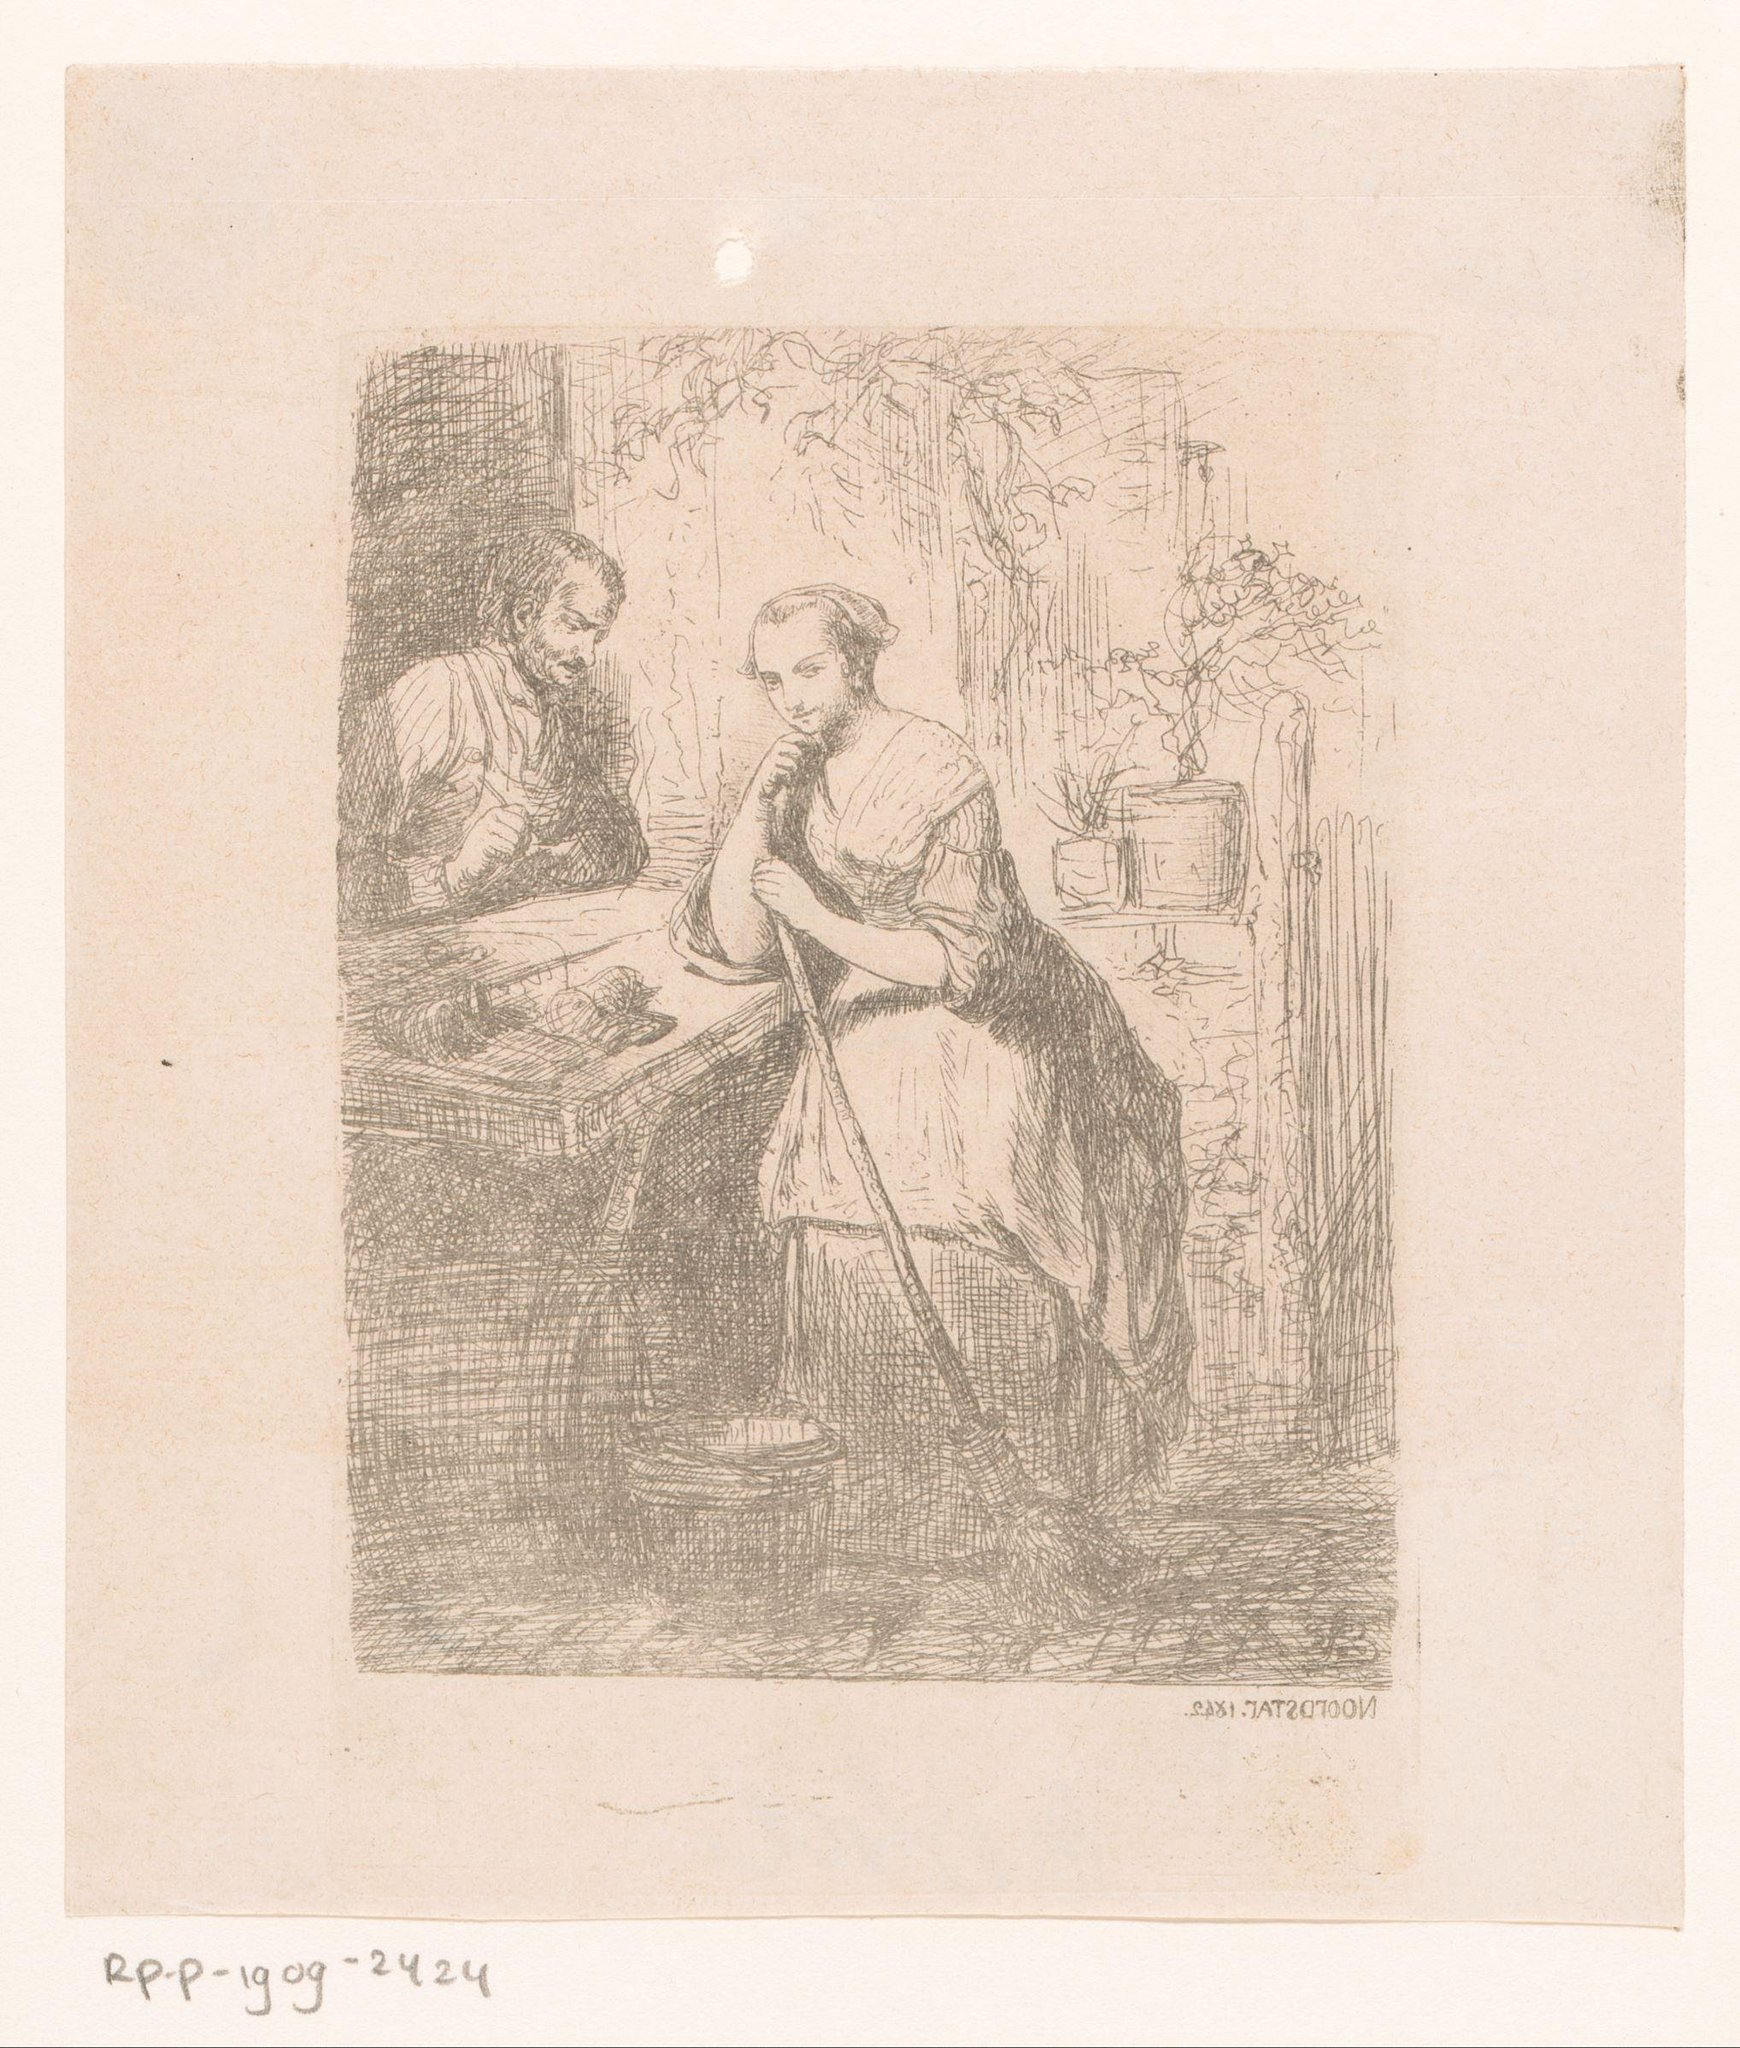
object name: print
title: Jonge vrouw bij een schoenmaker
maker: eugène françois de block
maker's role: draughtsman, painter, print maker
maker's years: 1812-1893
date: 1842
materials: paper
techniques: printmaking, etching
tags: adult woman, shoe-maker, cobbler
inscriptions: collector's mark: Lugt 2228, collector's mark: Lugt 1485